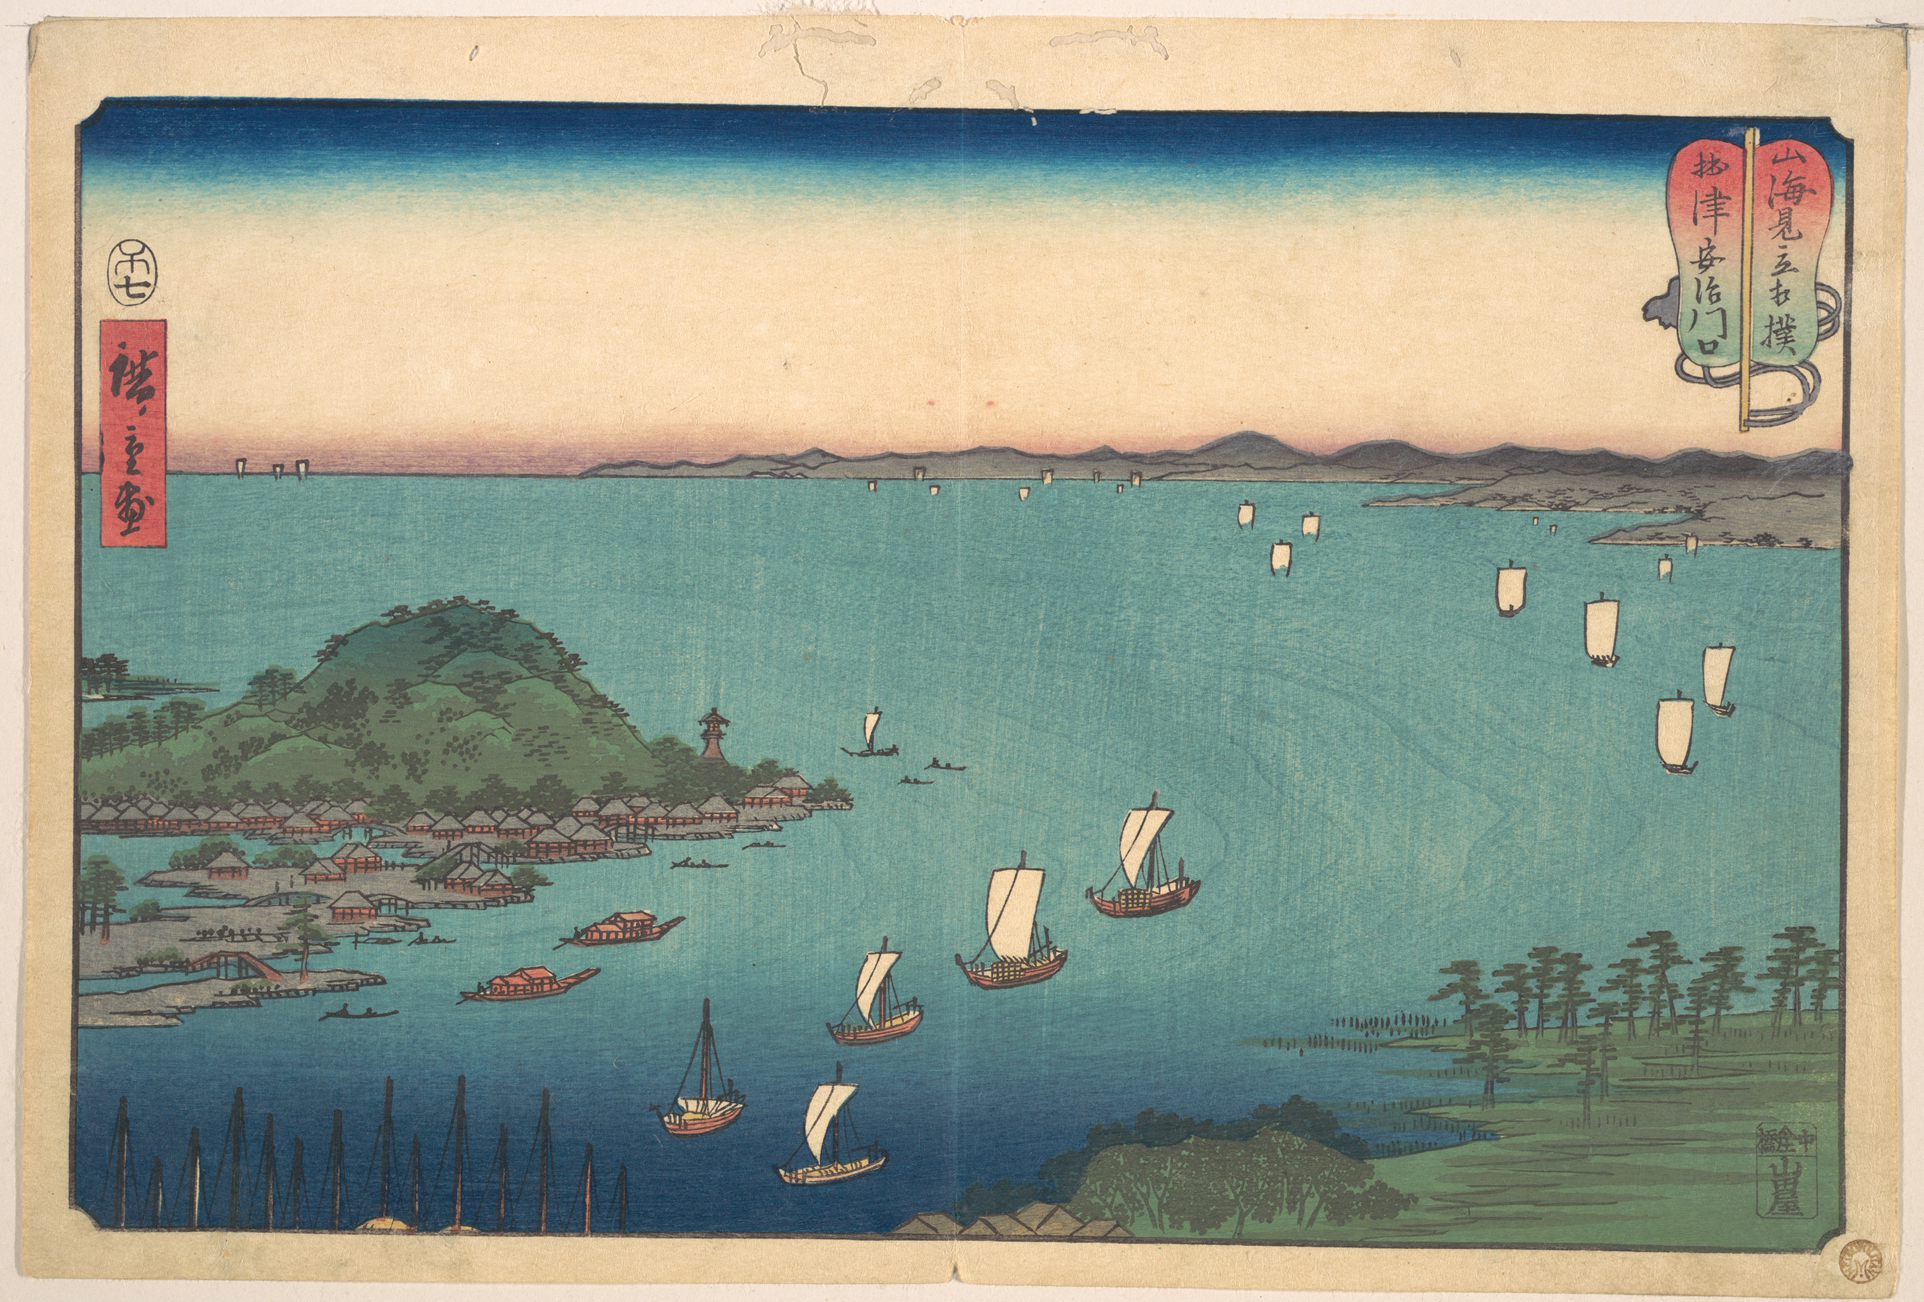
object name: print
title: The Harbor of Ajikawa, Settsu Province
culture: japanese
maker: utagawa hiroshige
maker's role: artist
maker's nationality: japanese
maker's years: 1797-1858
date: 1858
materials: ink, paper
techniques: woodblock print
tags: landscapes,boats